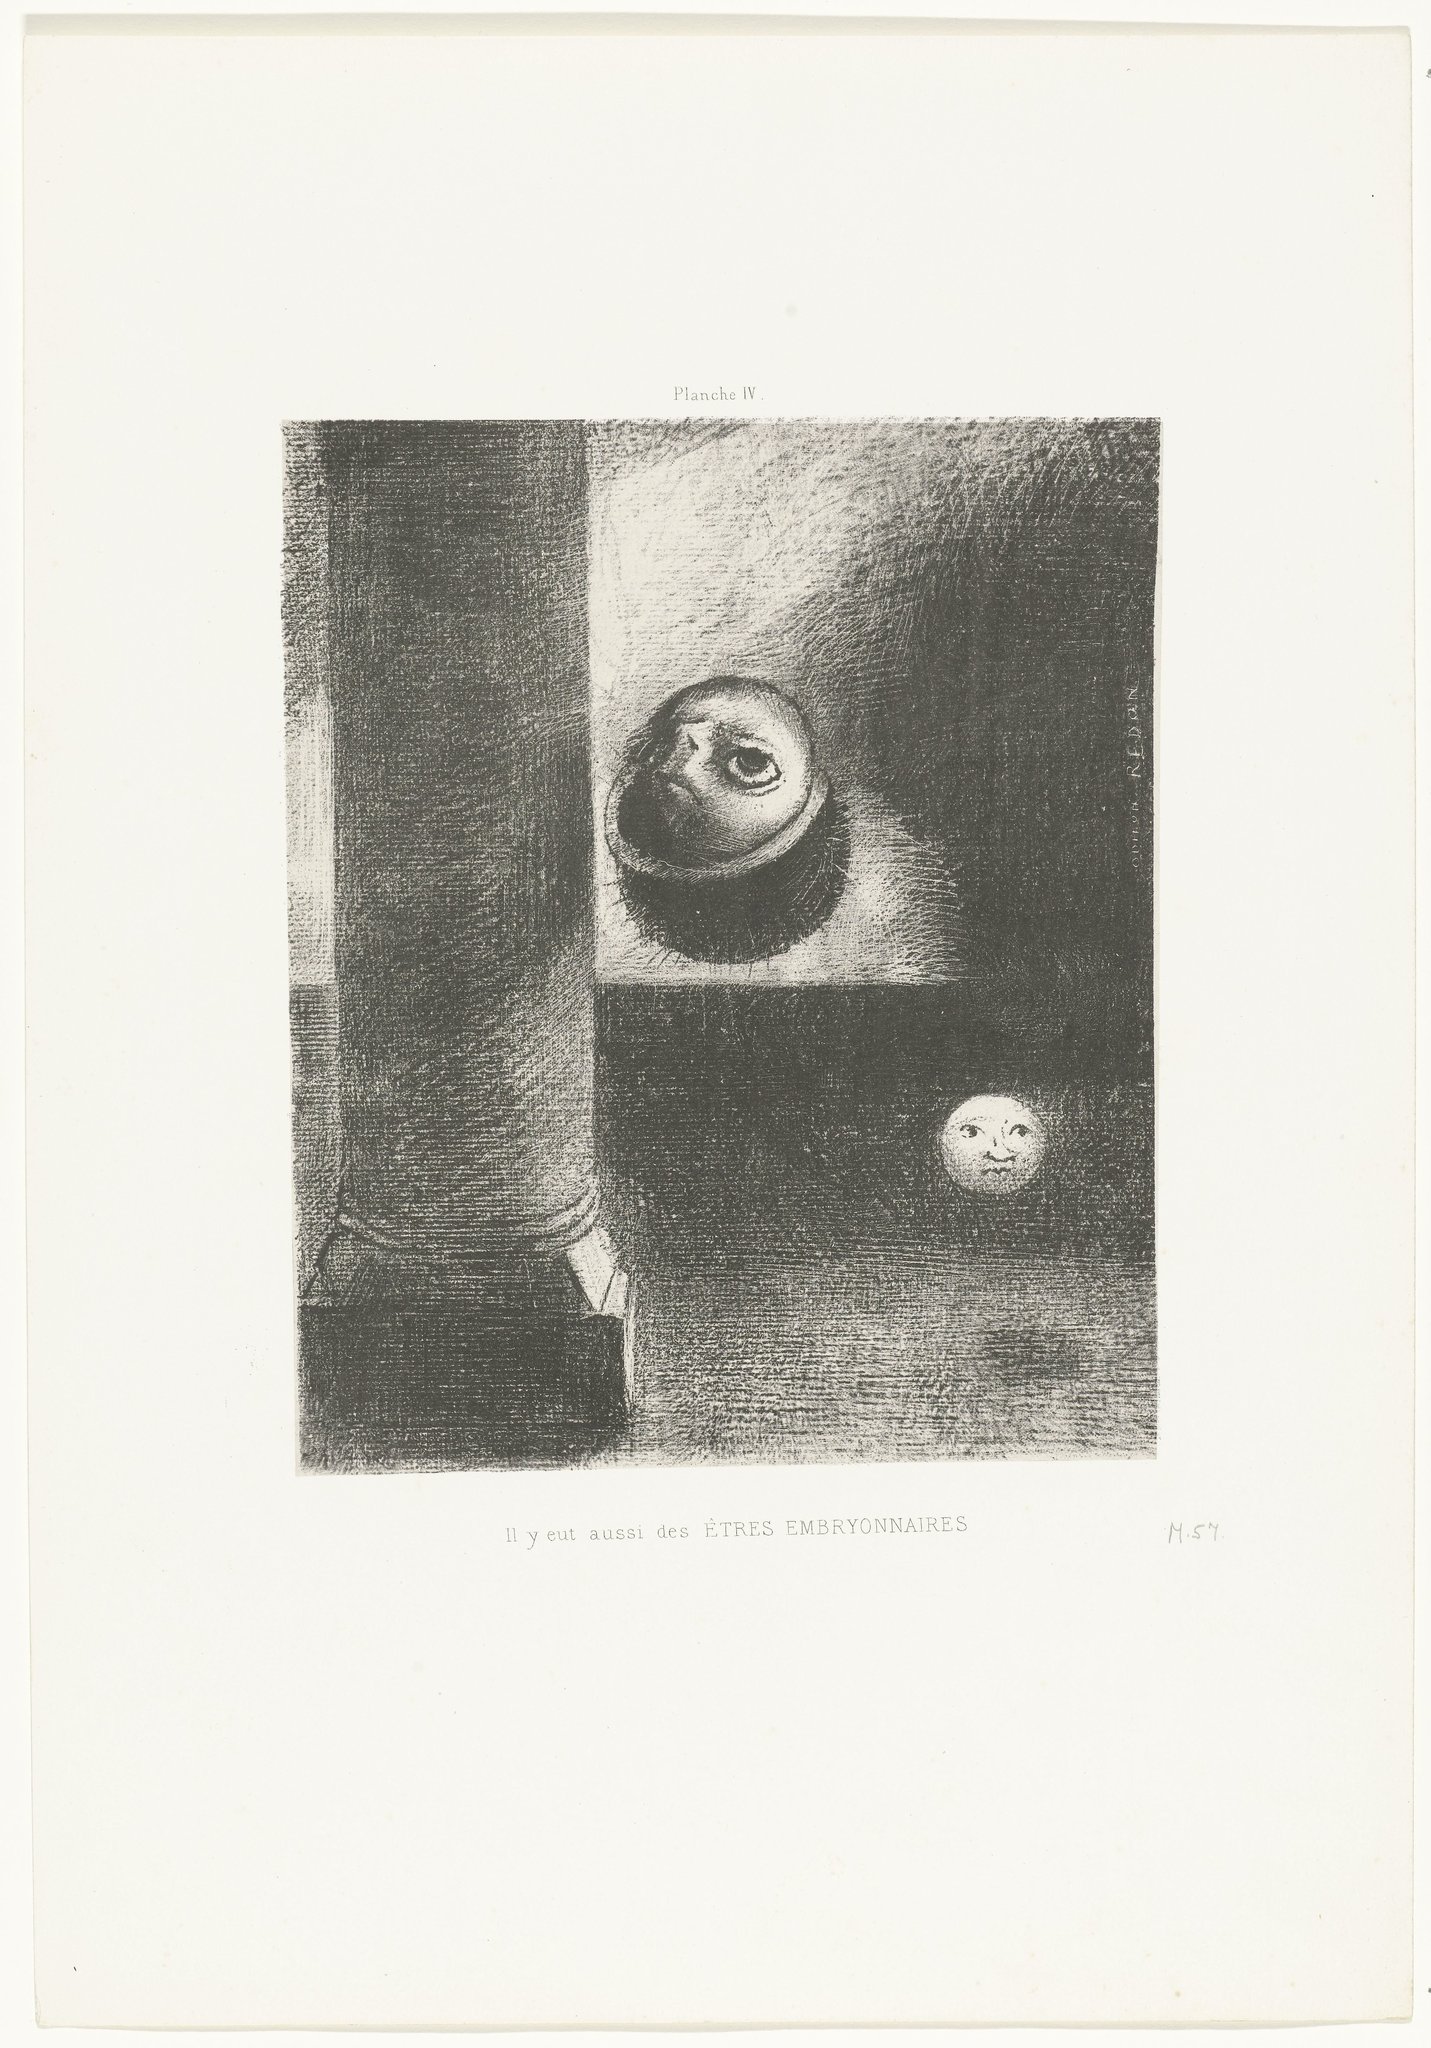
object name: print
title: Il y eut aussi des ETRES EMBRYONNAIRES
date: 1885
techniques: printmaking, lithograph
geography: paris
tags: column, pillar ~ architecture, foetus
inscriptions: collector's mark: Lugt 2228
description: Een zuil en twee bollen met een gezicht, waarvan één in een doosje. Vierde prent van zes uit het album "Hommage a Goya".